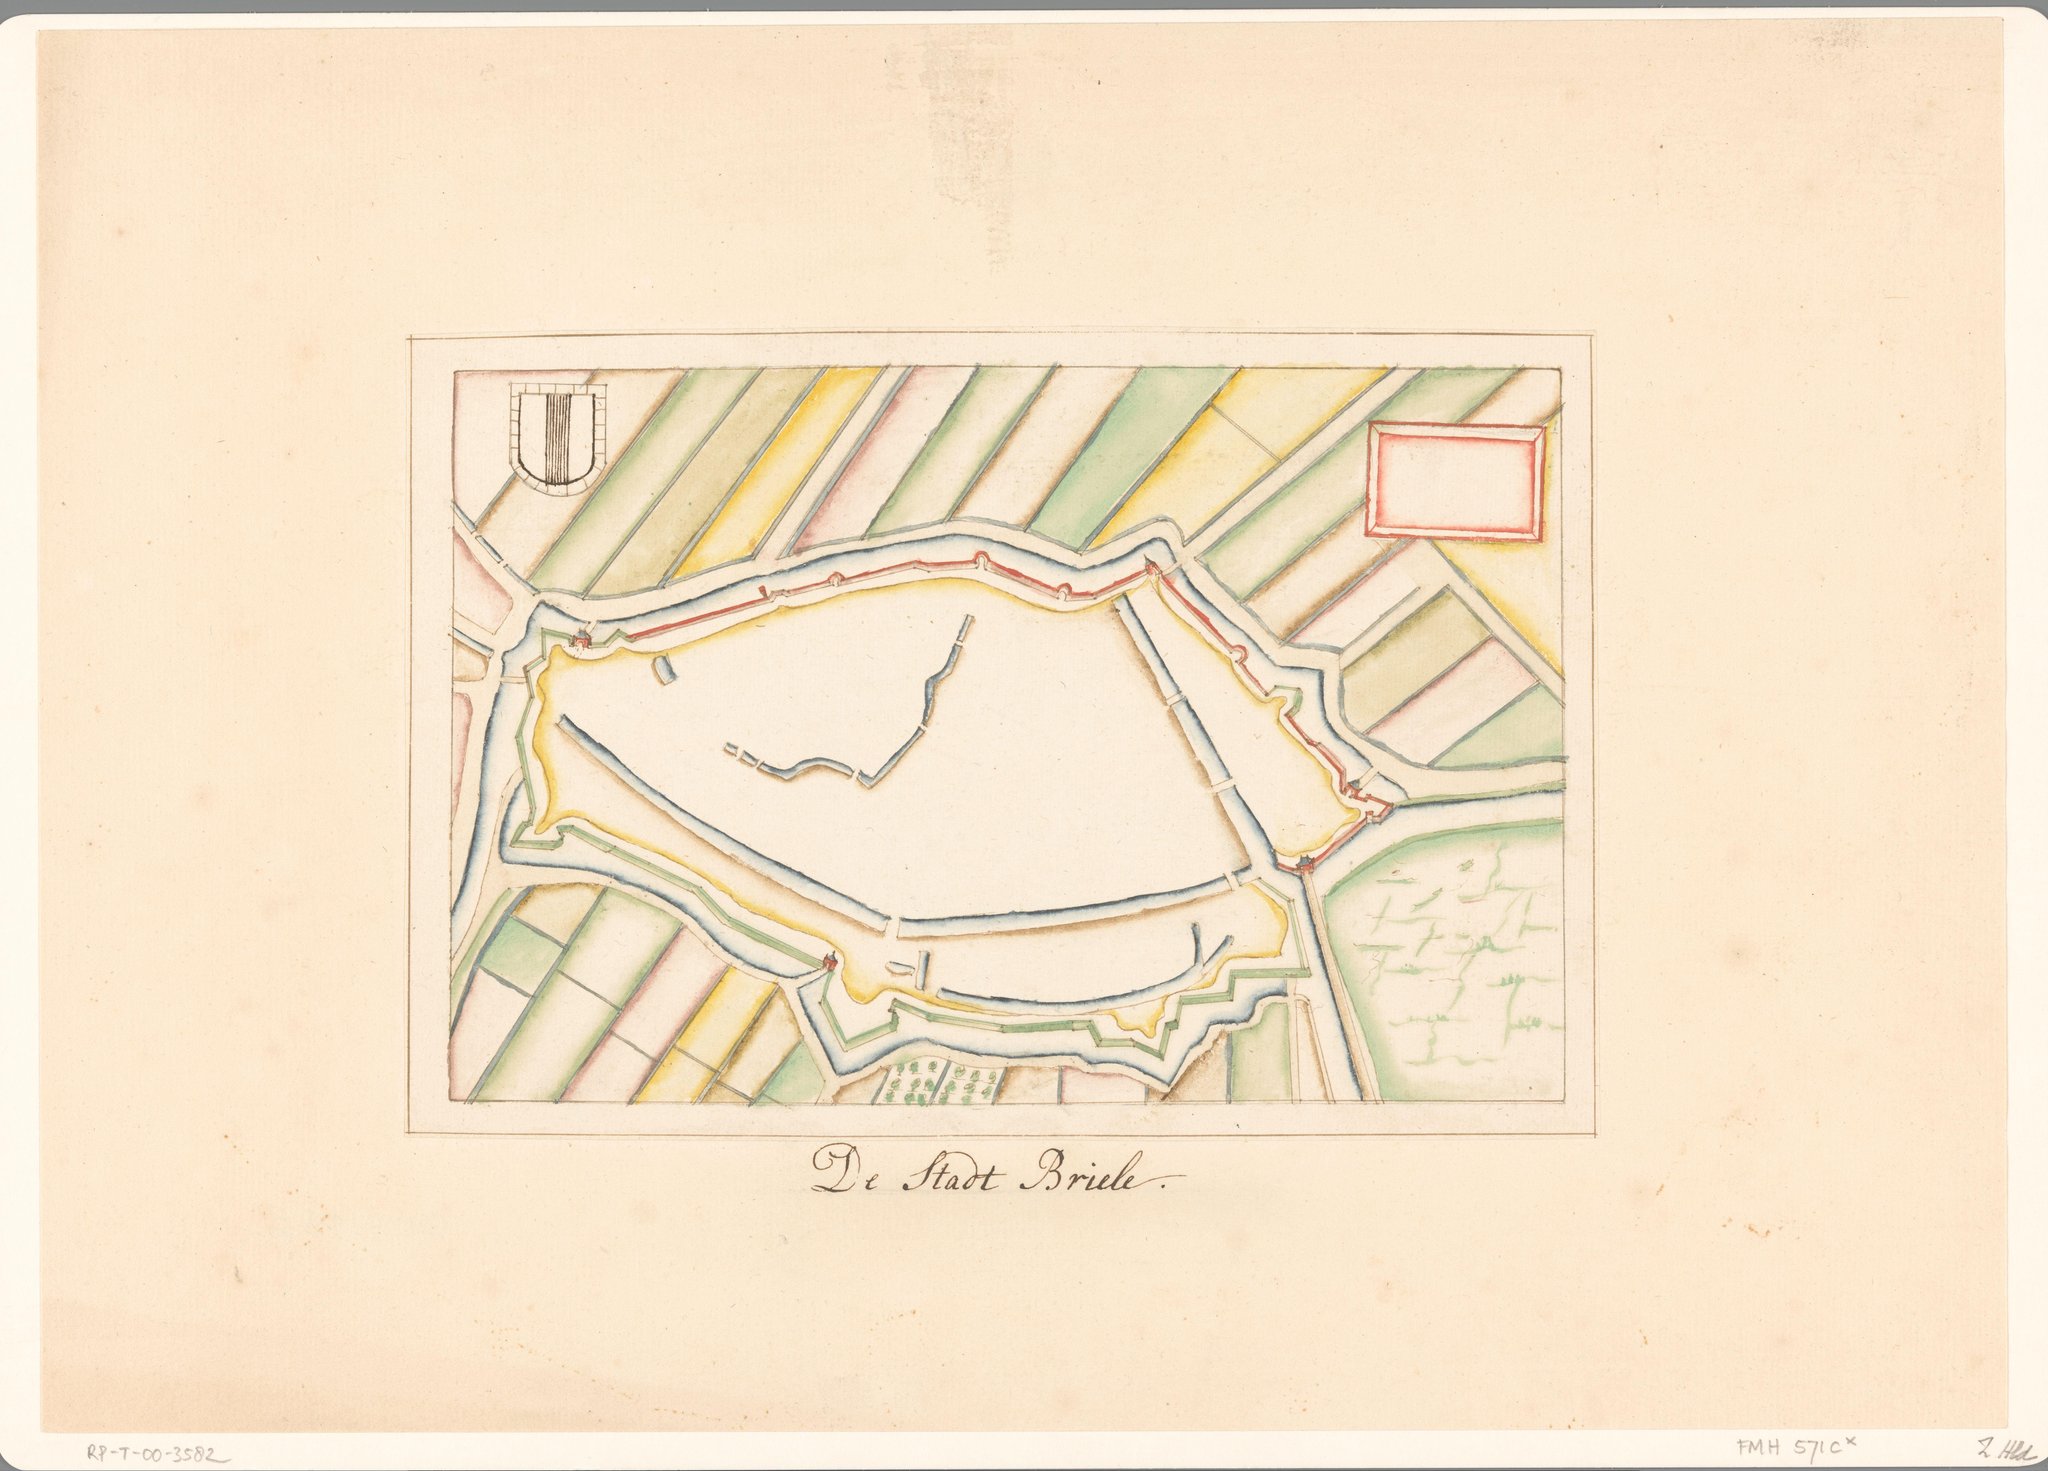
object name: drawing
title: Plan van Den Briel, ca. 1600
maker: Anonymous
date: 1675-1725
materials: ink, paper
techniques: brush, pen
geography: netherlands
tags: fortifications, military engineering, maps of cities, brielle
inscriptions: collector's mark: Lugt 2228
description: Plan van Den Briel en delen van het omliggende land. Op de kaart zijn alleen grachten, singels en stadswallen aangegeven, binnen de stad alleen een gracht. Wellicht een ingenieurstekening. Linksboven het stadswapen, rechtsboven een lege cartouche.